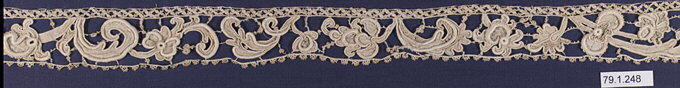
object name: fragment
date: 1601-1700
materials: lace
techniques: gros point, lace